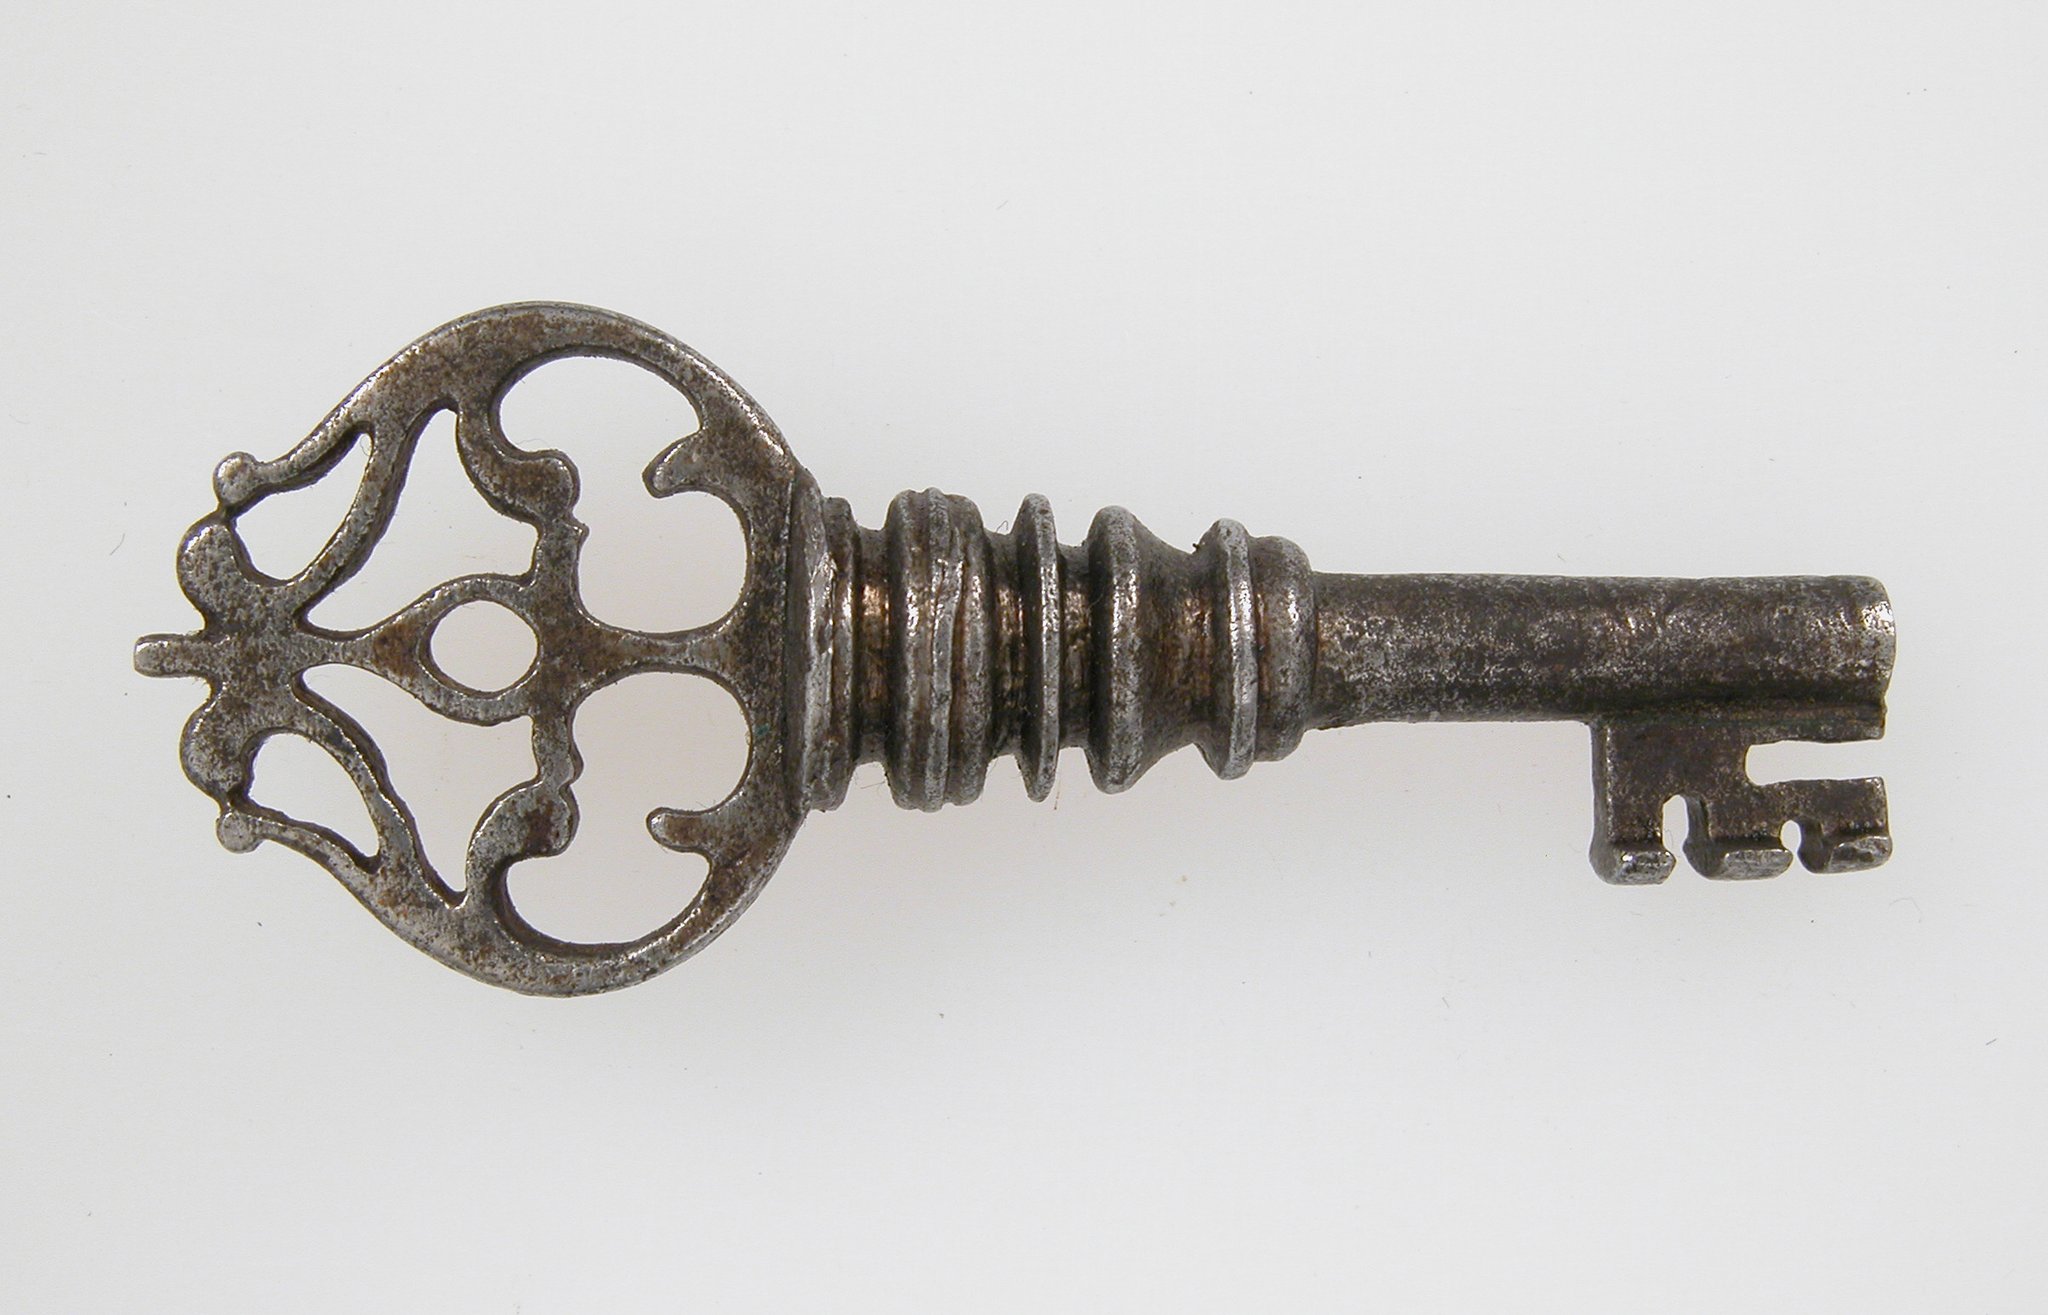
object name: key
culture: german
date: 1401-1500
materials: iron